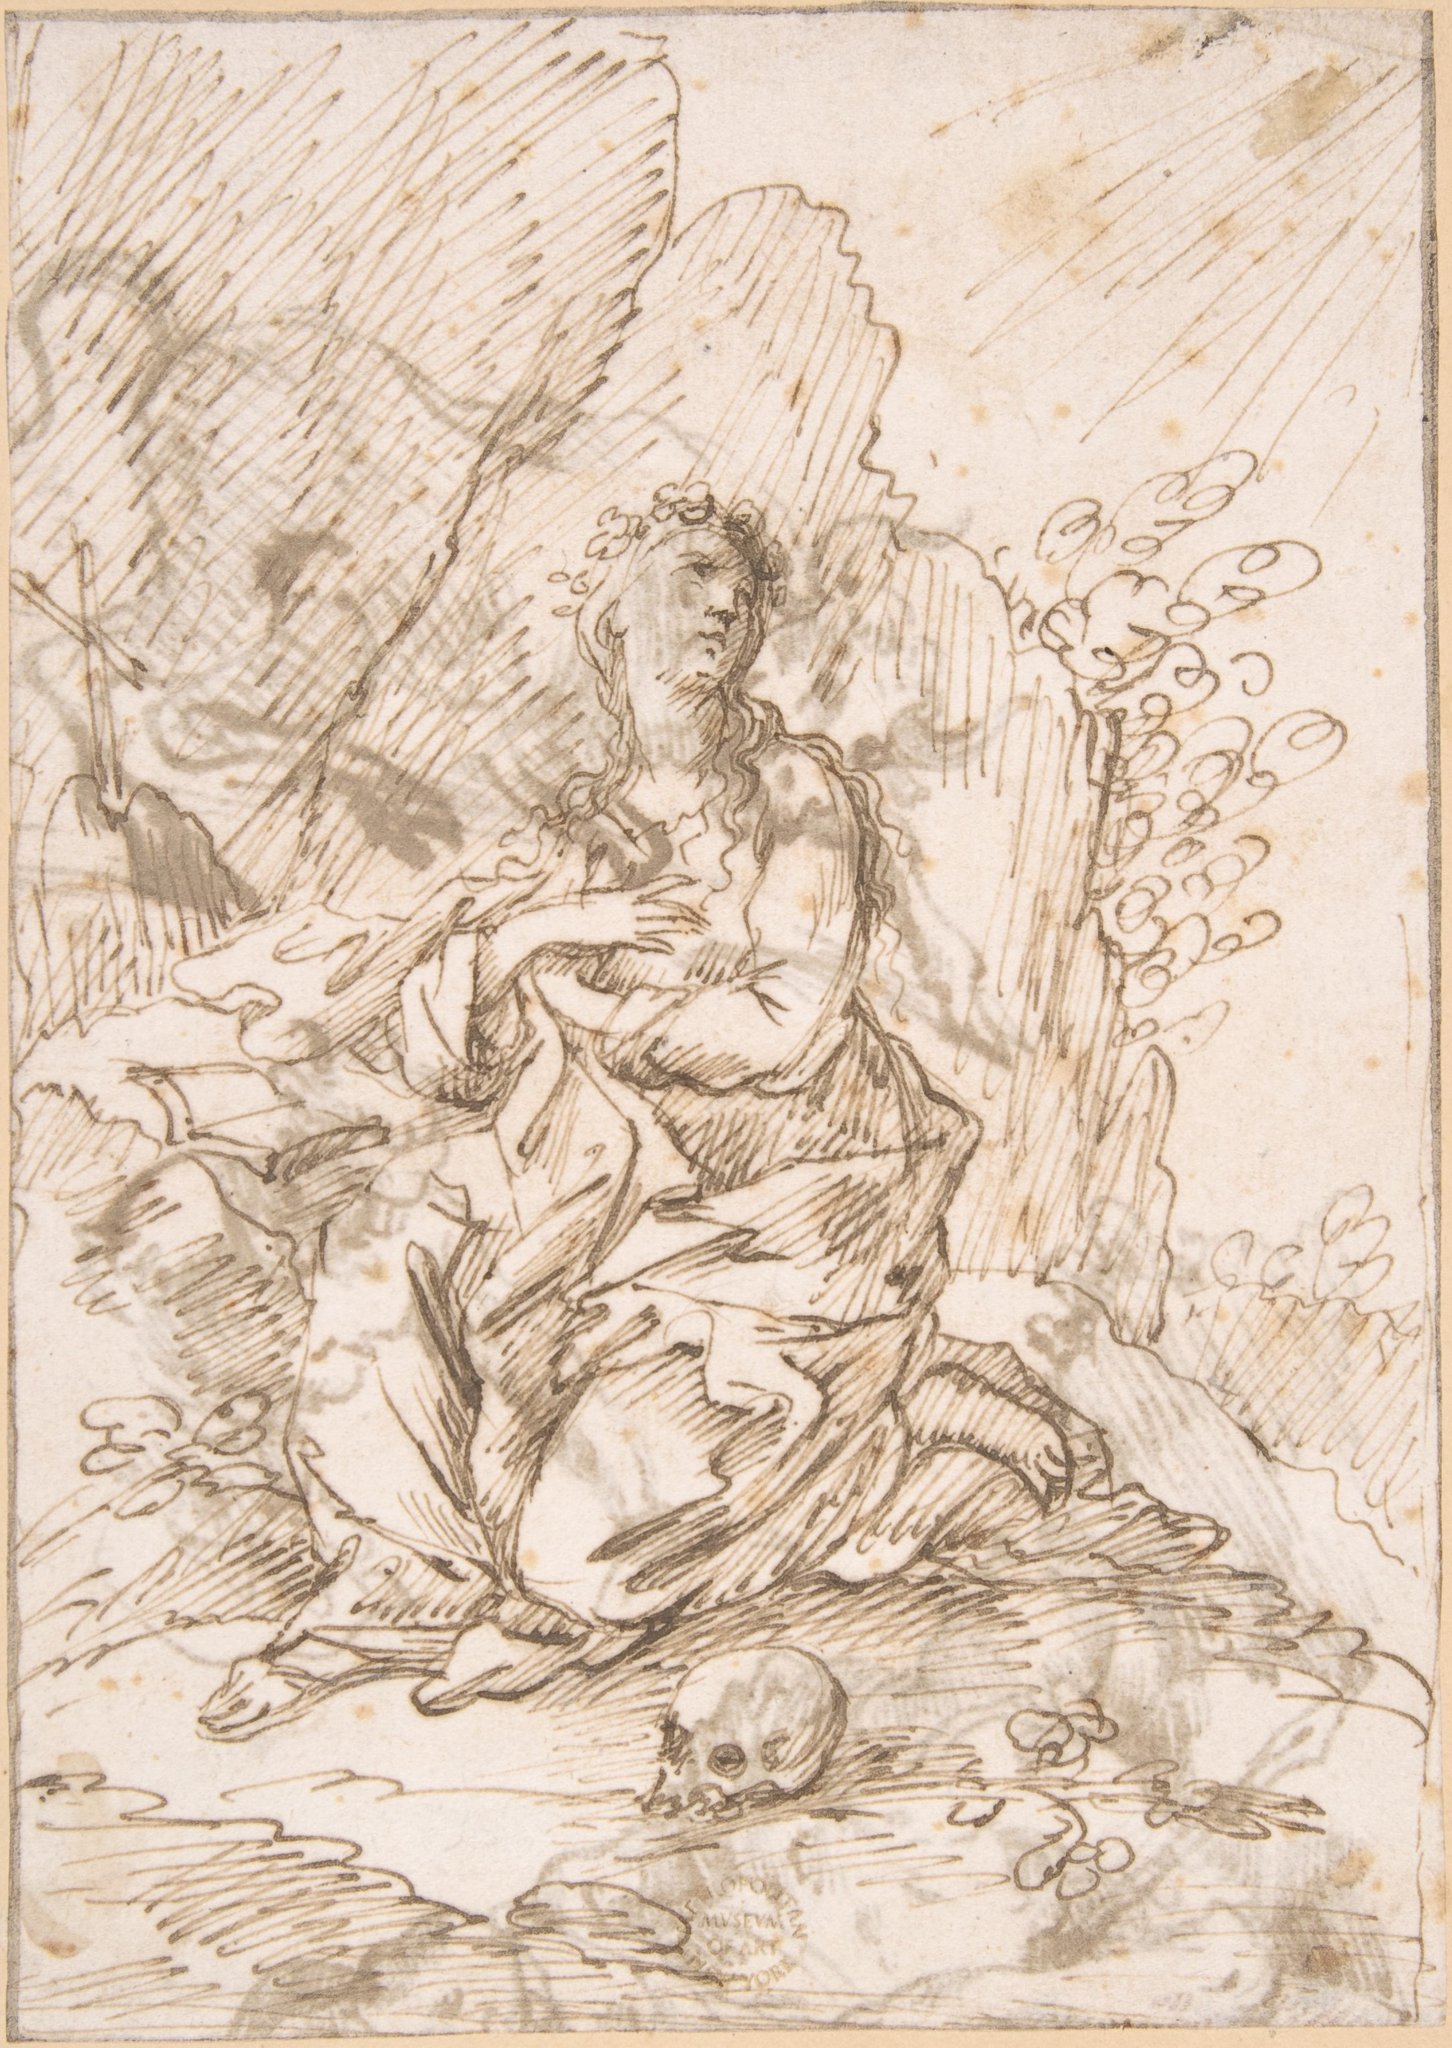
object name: drawing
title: Mary Magdalen in the Wilderness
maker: anonymous, italian, roman-bolognese, 17th century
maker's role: artist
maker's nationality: italian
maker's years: 1600-1700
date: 1601-1700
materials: ink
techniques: pen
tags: skulls,mary magdalene,cross